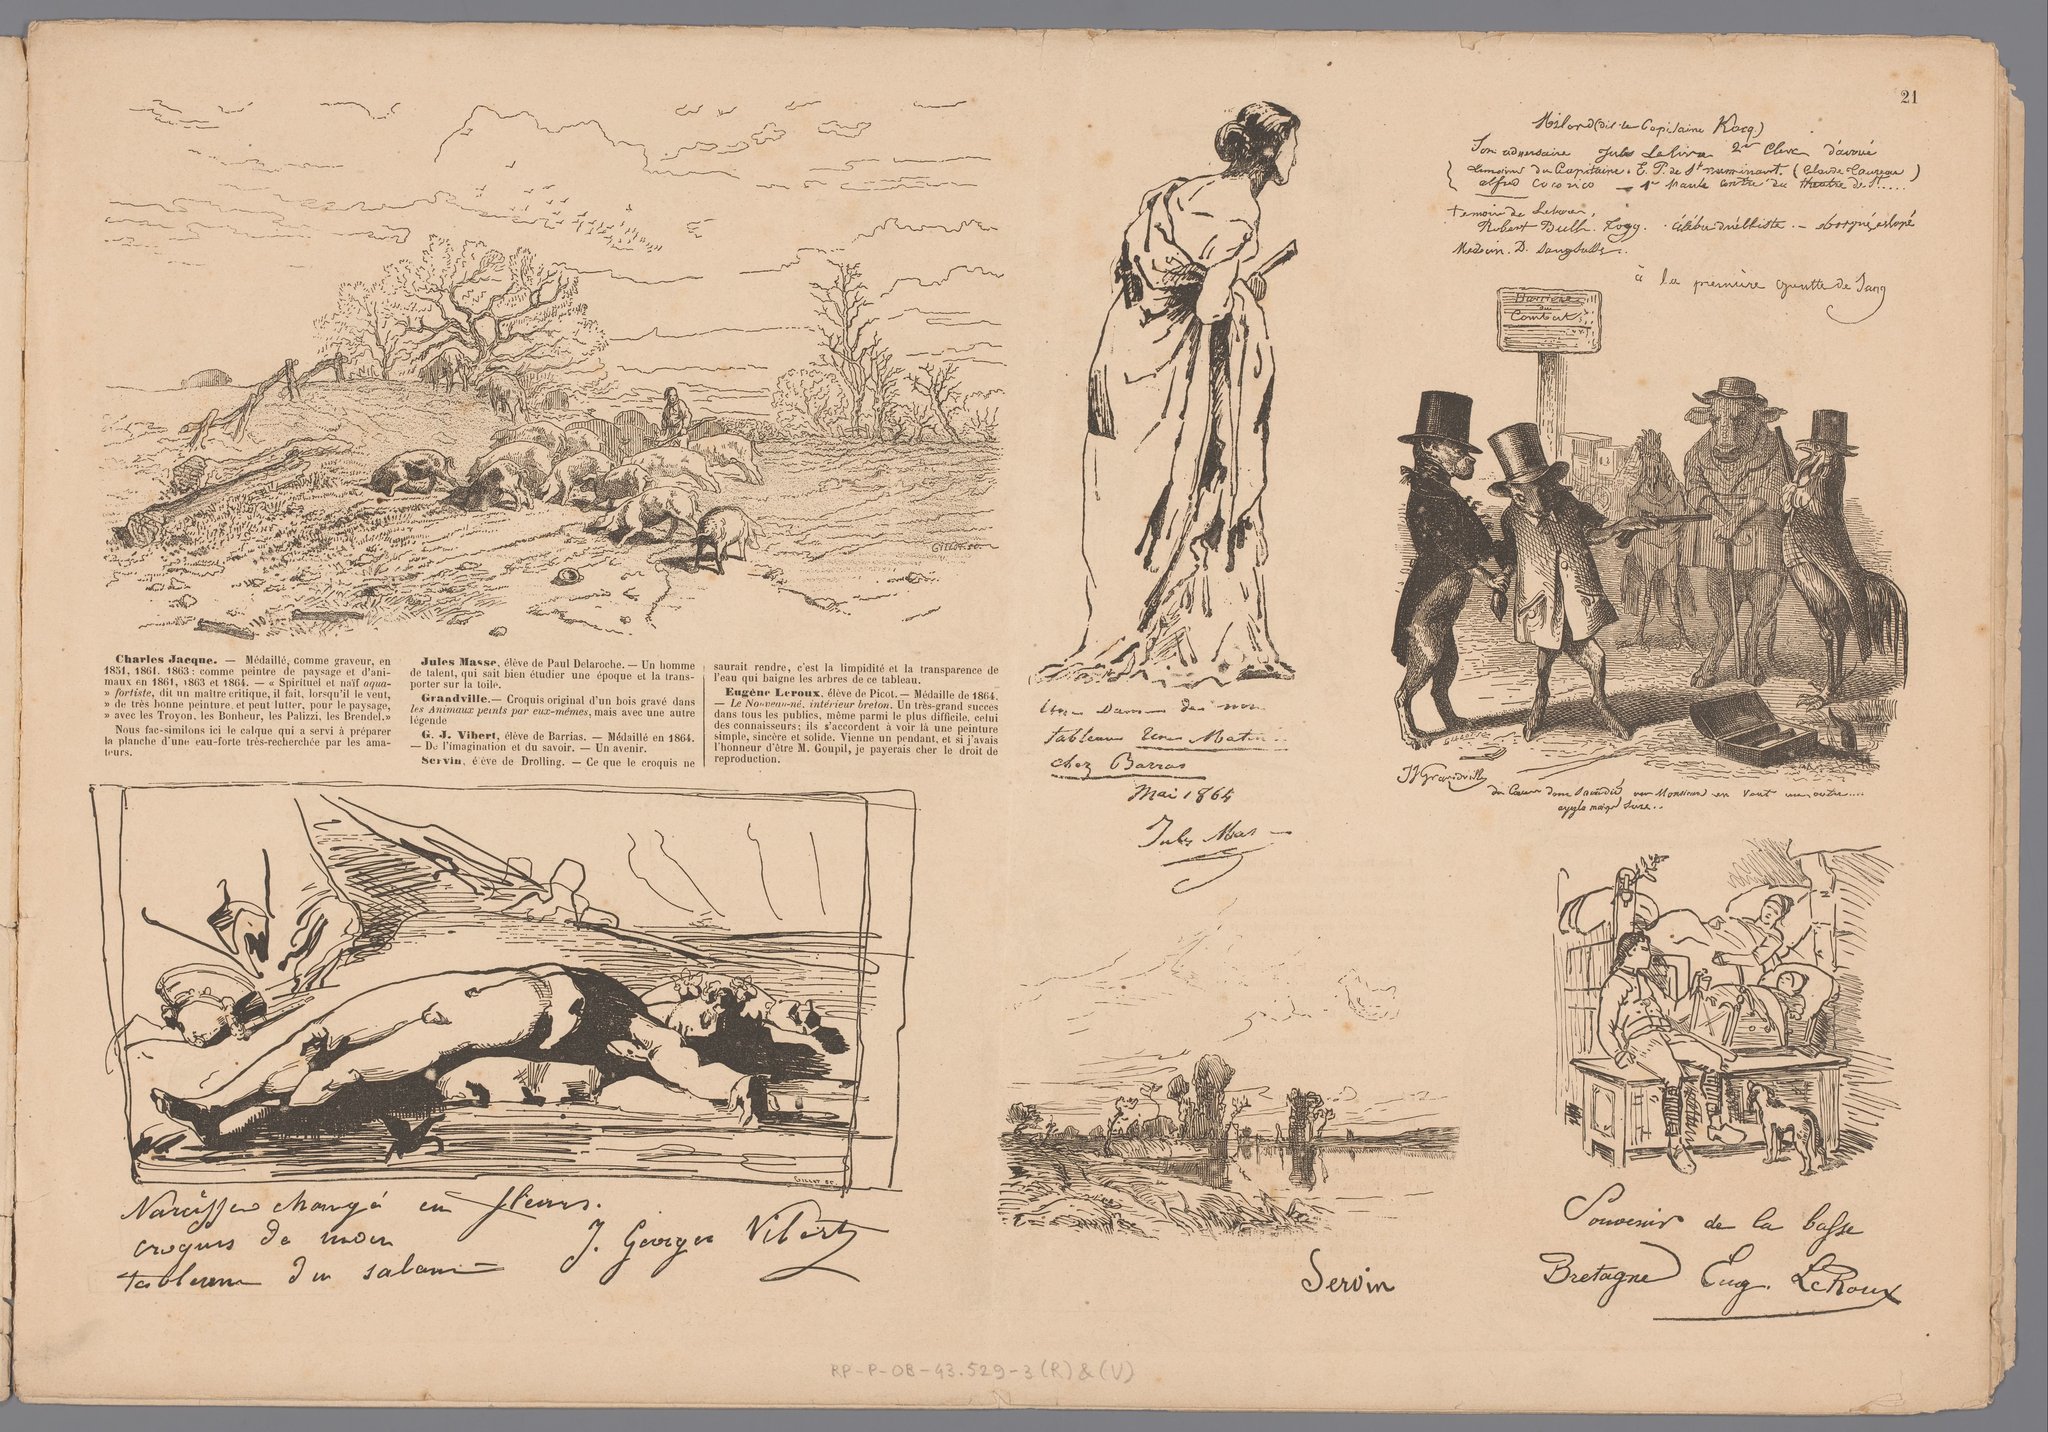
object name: print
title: Varkenshoeder, staande vrouw, dieren verkleed als mensen, Narcissus, een landschap en twee figuren in een bed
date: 1864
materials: paper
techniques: gillotage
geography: paris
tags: (story of) narcissus, animals acting as human beings, driving pigs to the wood to eat acorns